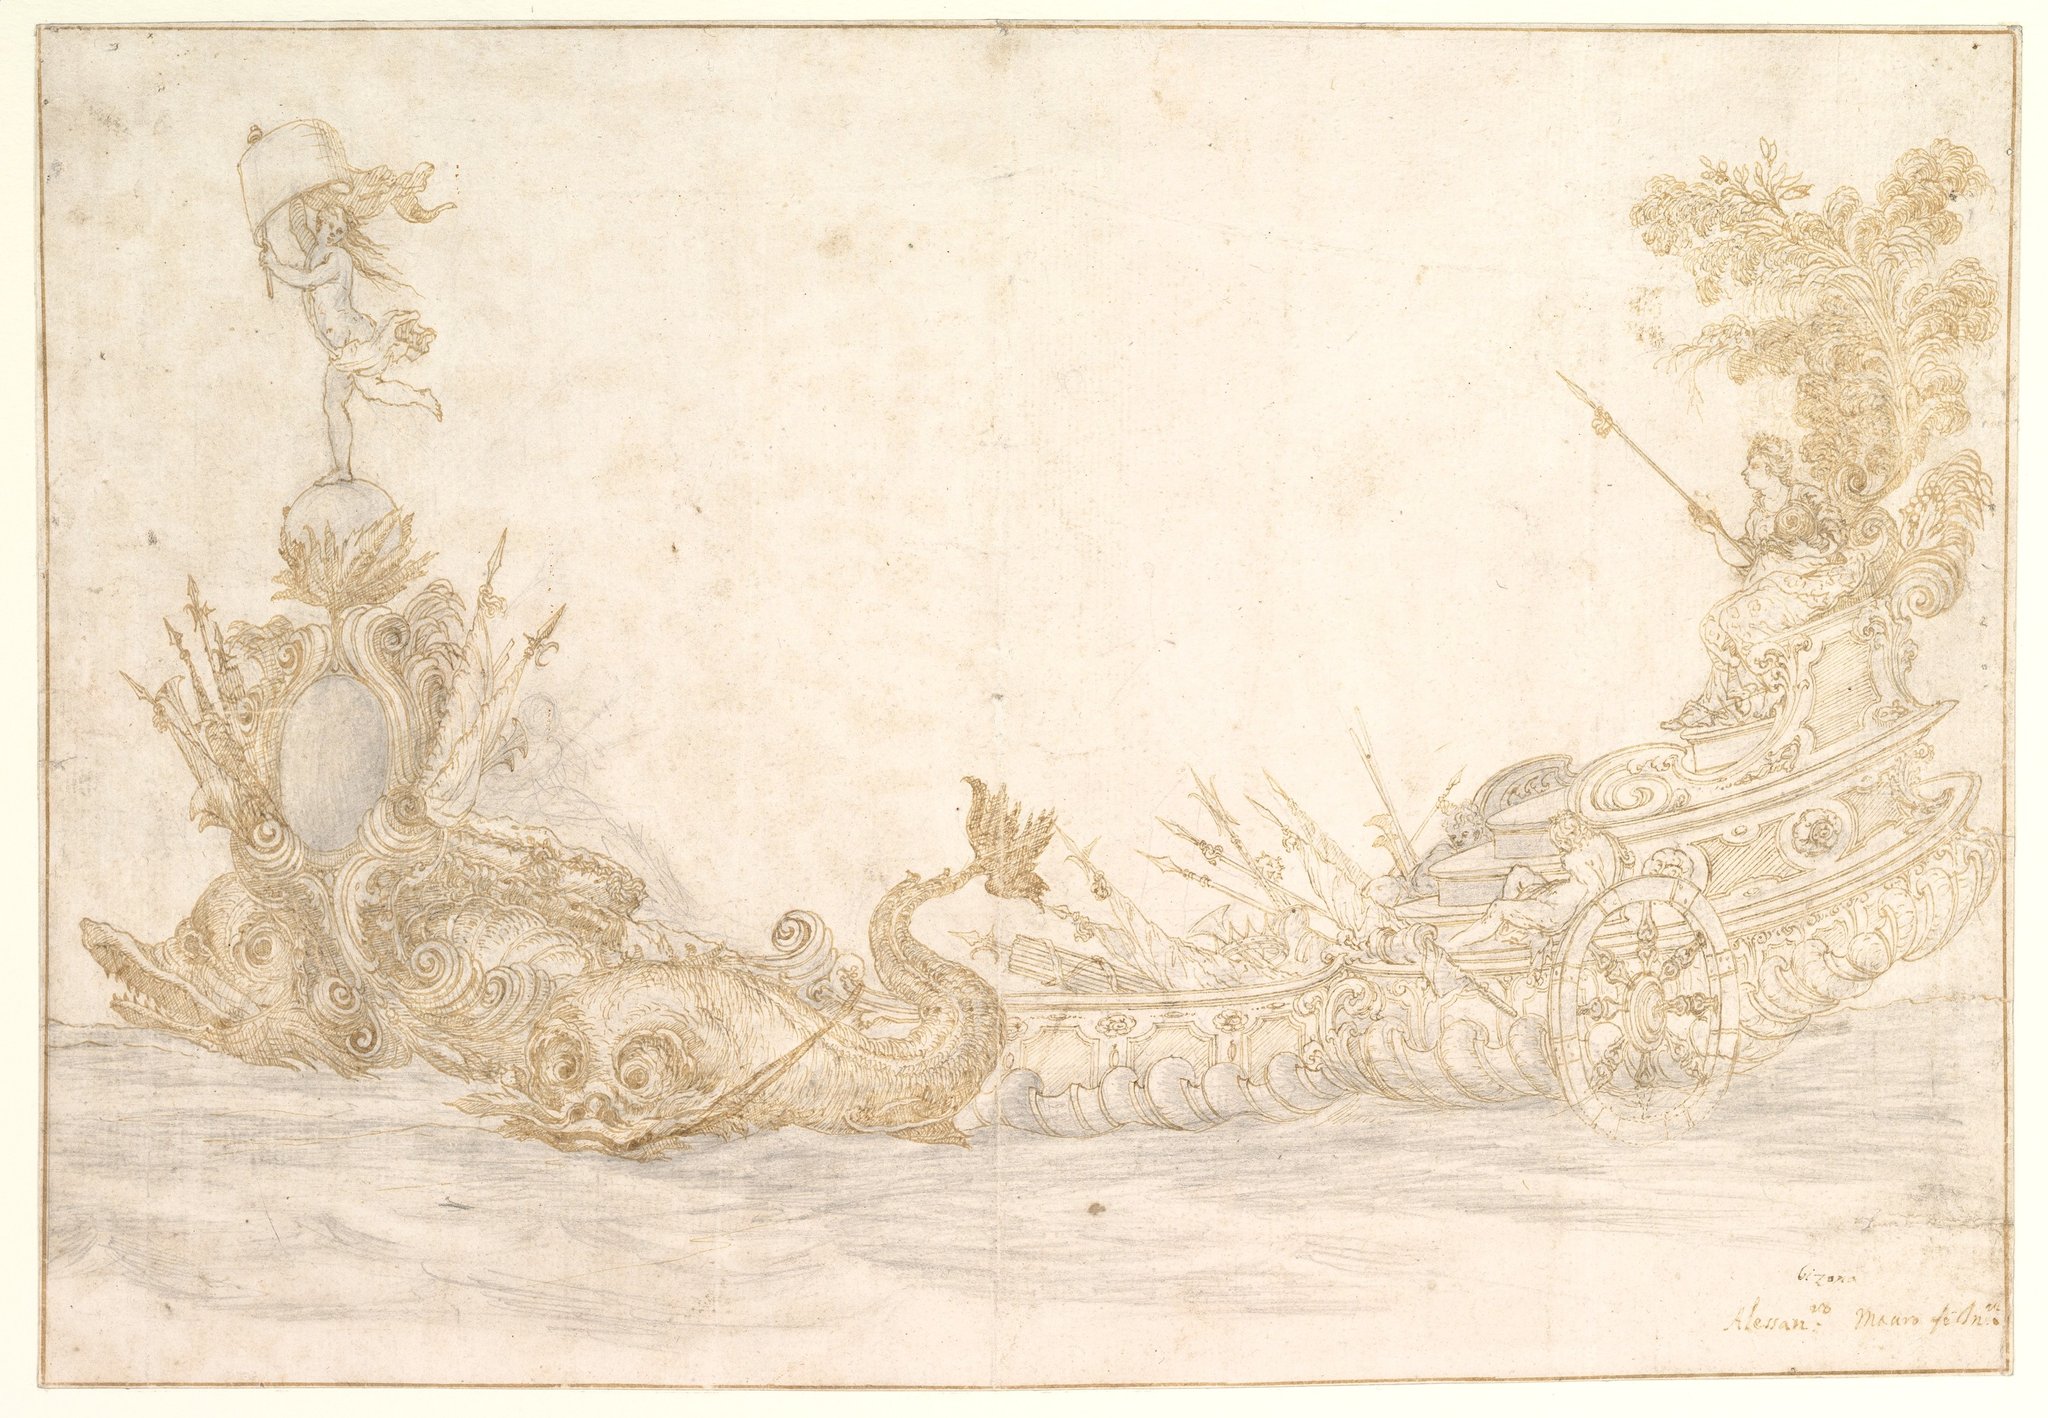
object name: drawing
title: Design for a Festival Gondola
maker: alessandro mauro (mauri)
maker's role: artist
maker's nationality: italian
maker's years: 1711-1748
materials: graphite, ink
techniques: pen